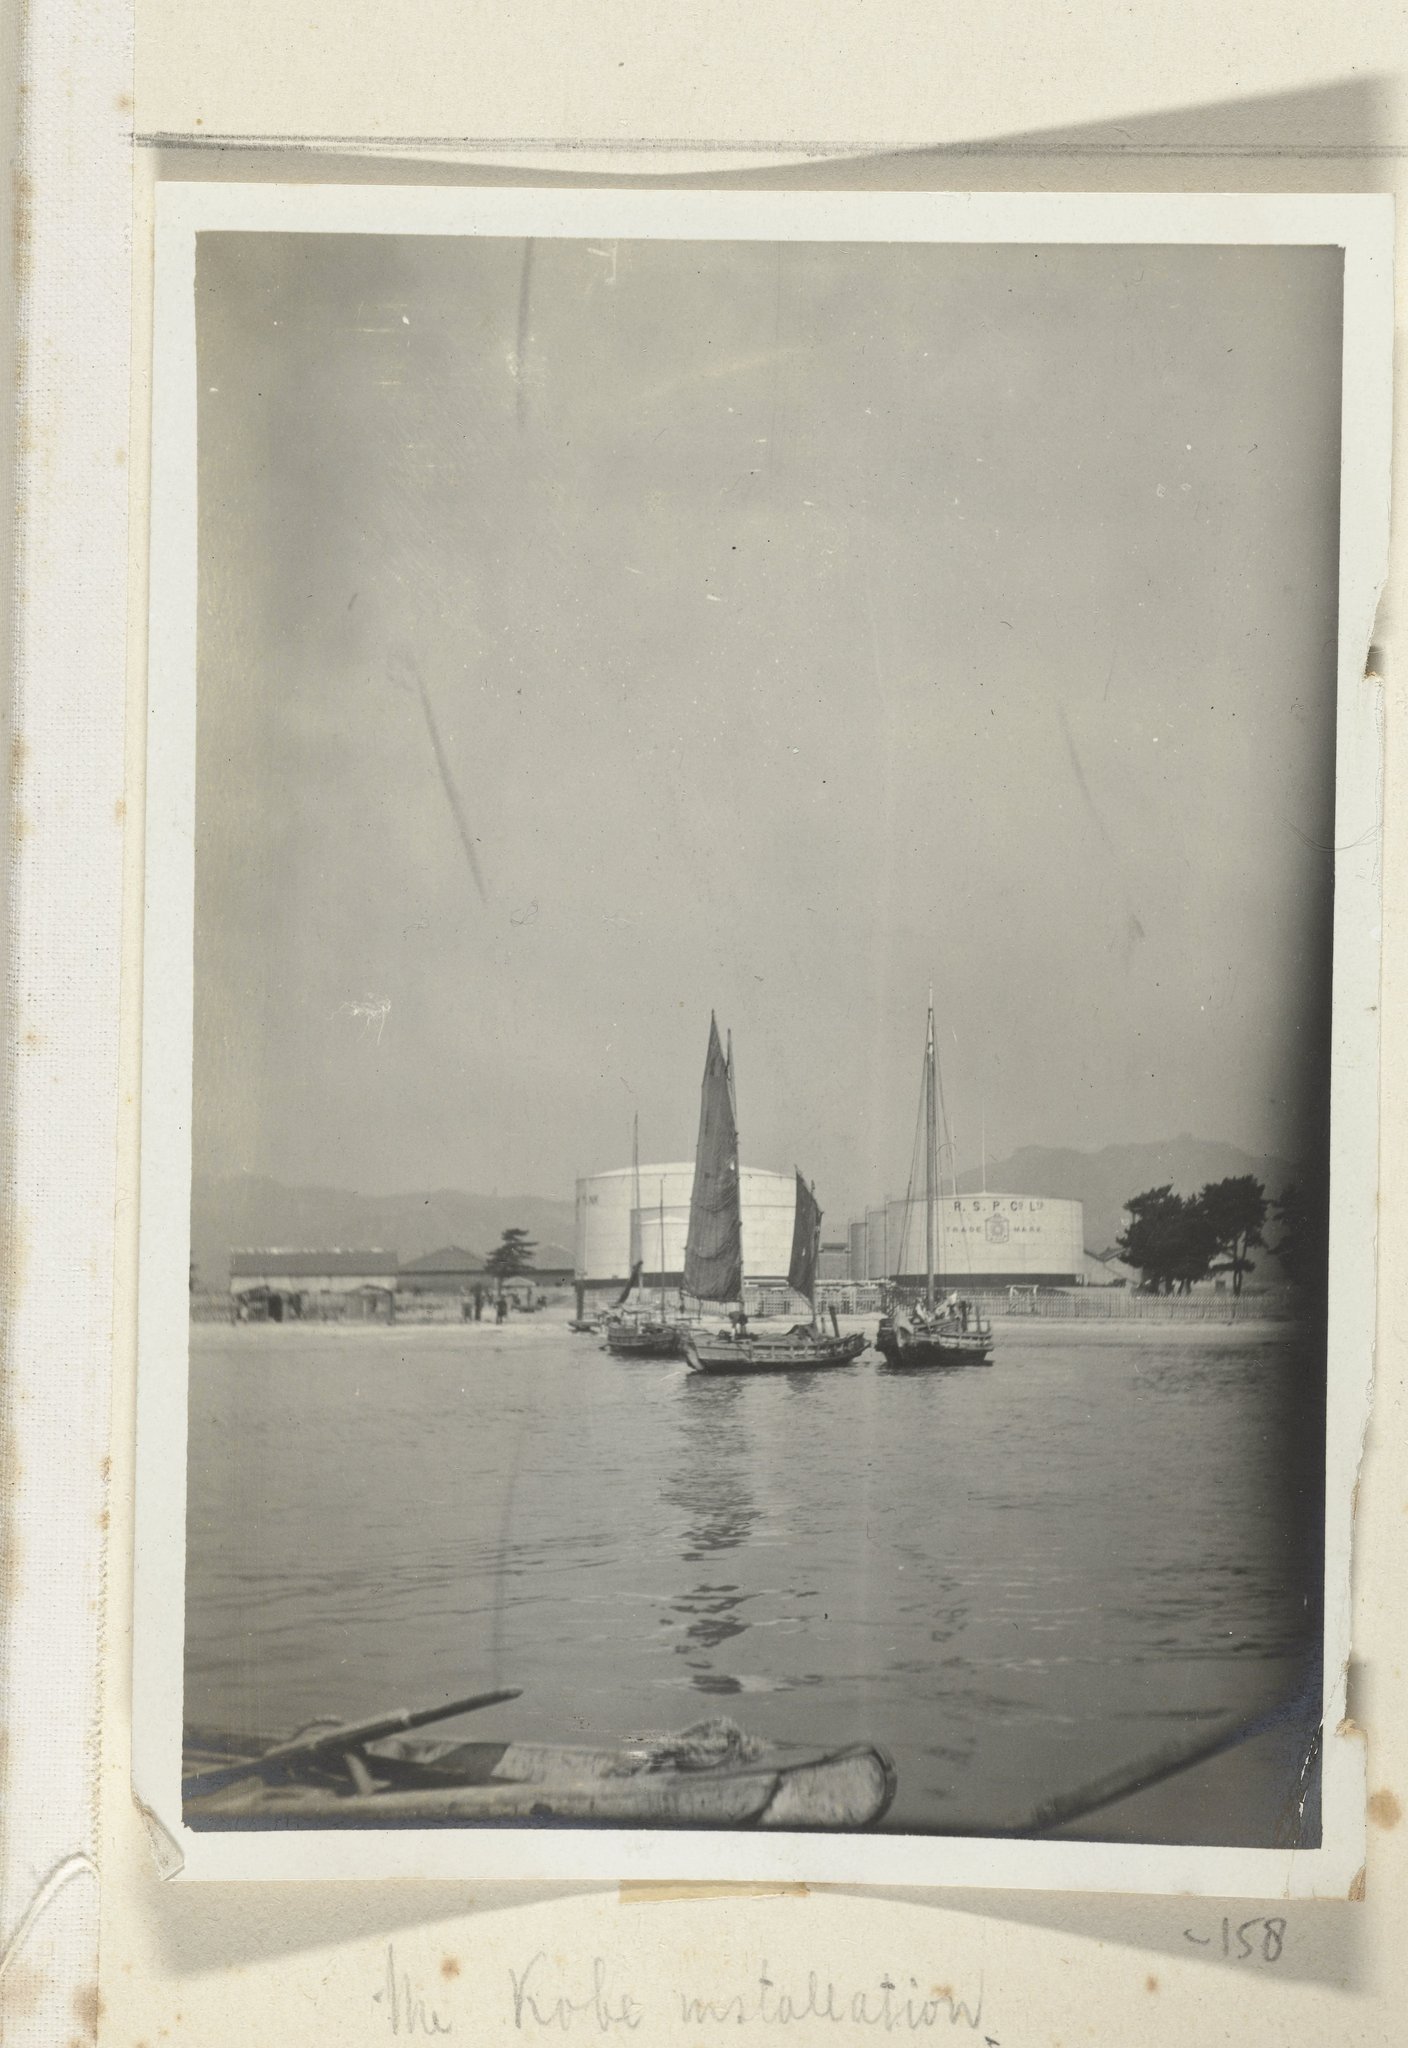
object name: photograph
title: The Kobe installation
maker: geldolph adriaan kessler (dolph)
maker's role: fotograaf, industrieel, voetballer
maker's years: 1884-1945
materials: cardboard, photographic support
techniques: gelatin silver print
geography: kobe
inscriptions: title: ‘The Kobe installation’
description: Gas en olie-installatie in Kobe in Japan. Onderdeel van het fotoalbum van Dolph Kessler met opnamen die hij maakte tijdens zijn verblijf in Engeland en op een wereldreis die hij als secretaris van Henri Deterding (directeur Koninklijke Olie) ondernam naar Nederlands-Indië, Japan, China en de Verenigde Staten, tussen 1906 en 1908.